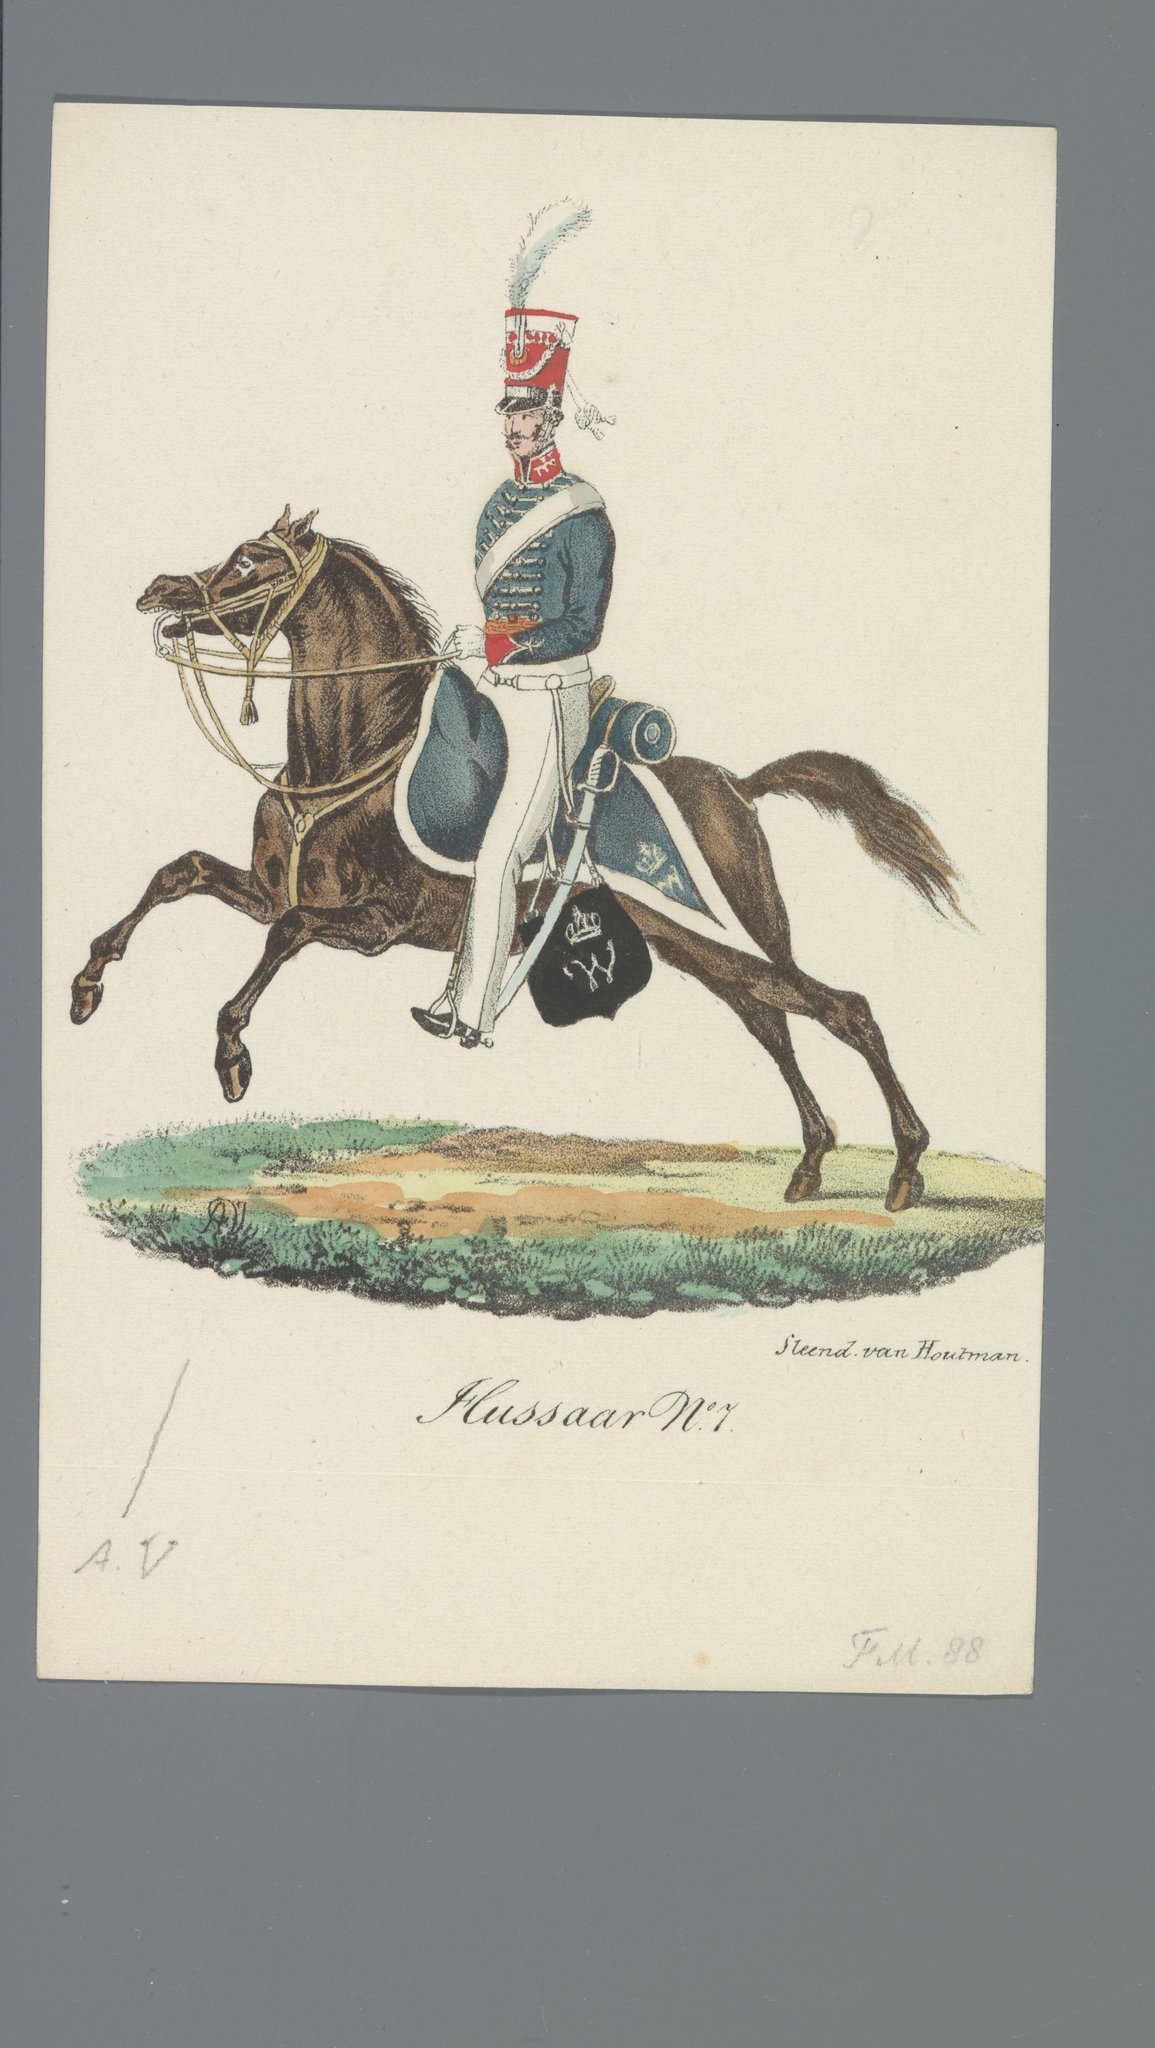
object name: print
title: Nederlandse militaire uniformen in de jaren 1830-1832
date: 1835-1850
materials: paper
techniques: hand coloring, lithograph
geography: netherlands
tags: (military) uniforms, clothes, costume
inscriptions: collector's mark: Lugt 2228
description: Een huzaar van het Regiment Huzaren Nr 7 (mogelijk te Oost-Indië), te paard. Onderdeel van een serie van 157 losse bladen met Nederlandse militaire uniformen in de jaren 1830-1832.